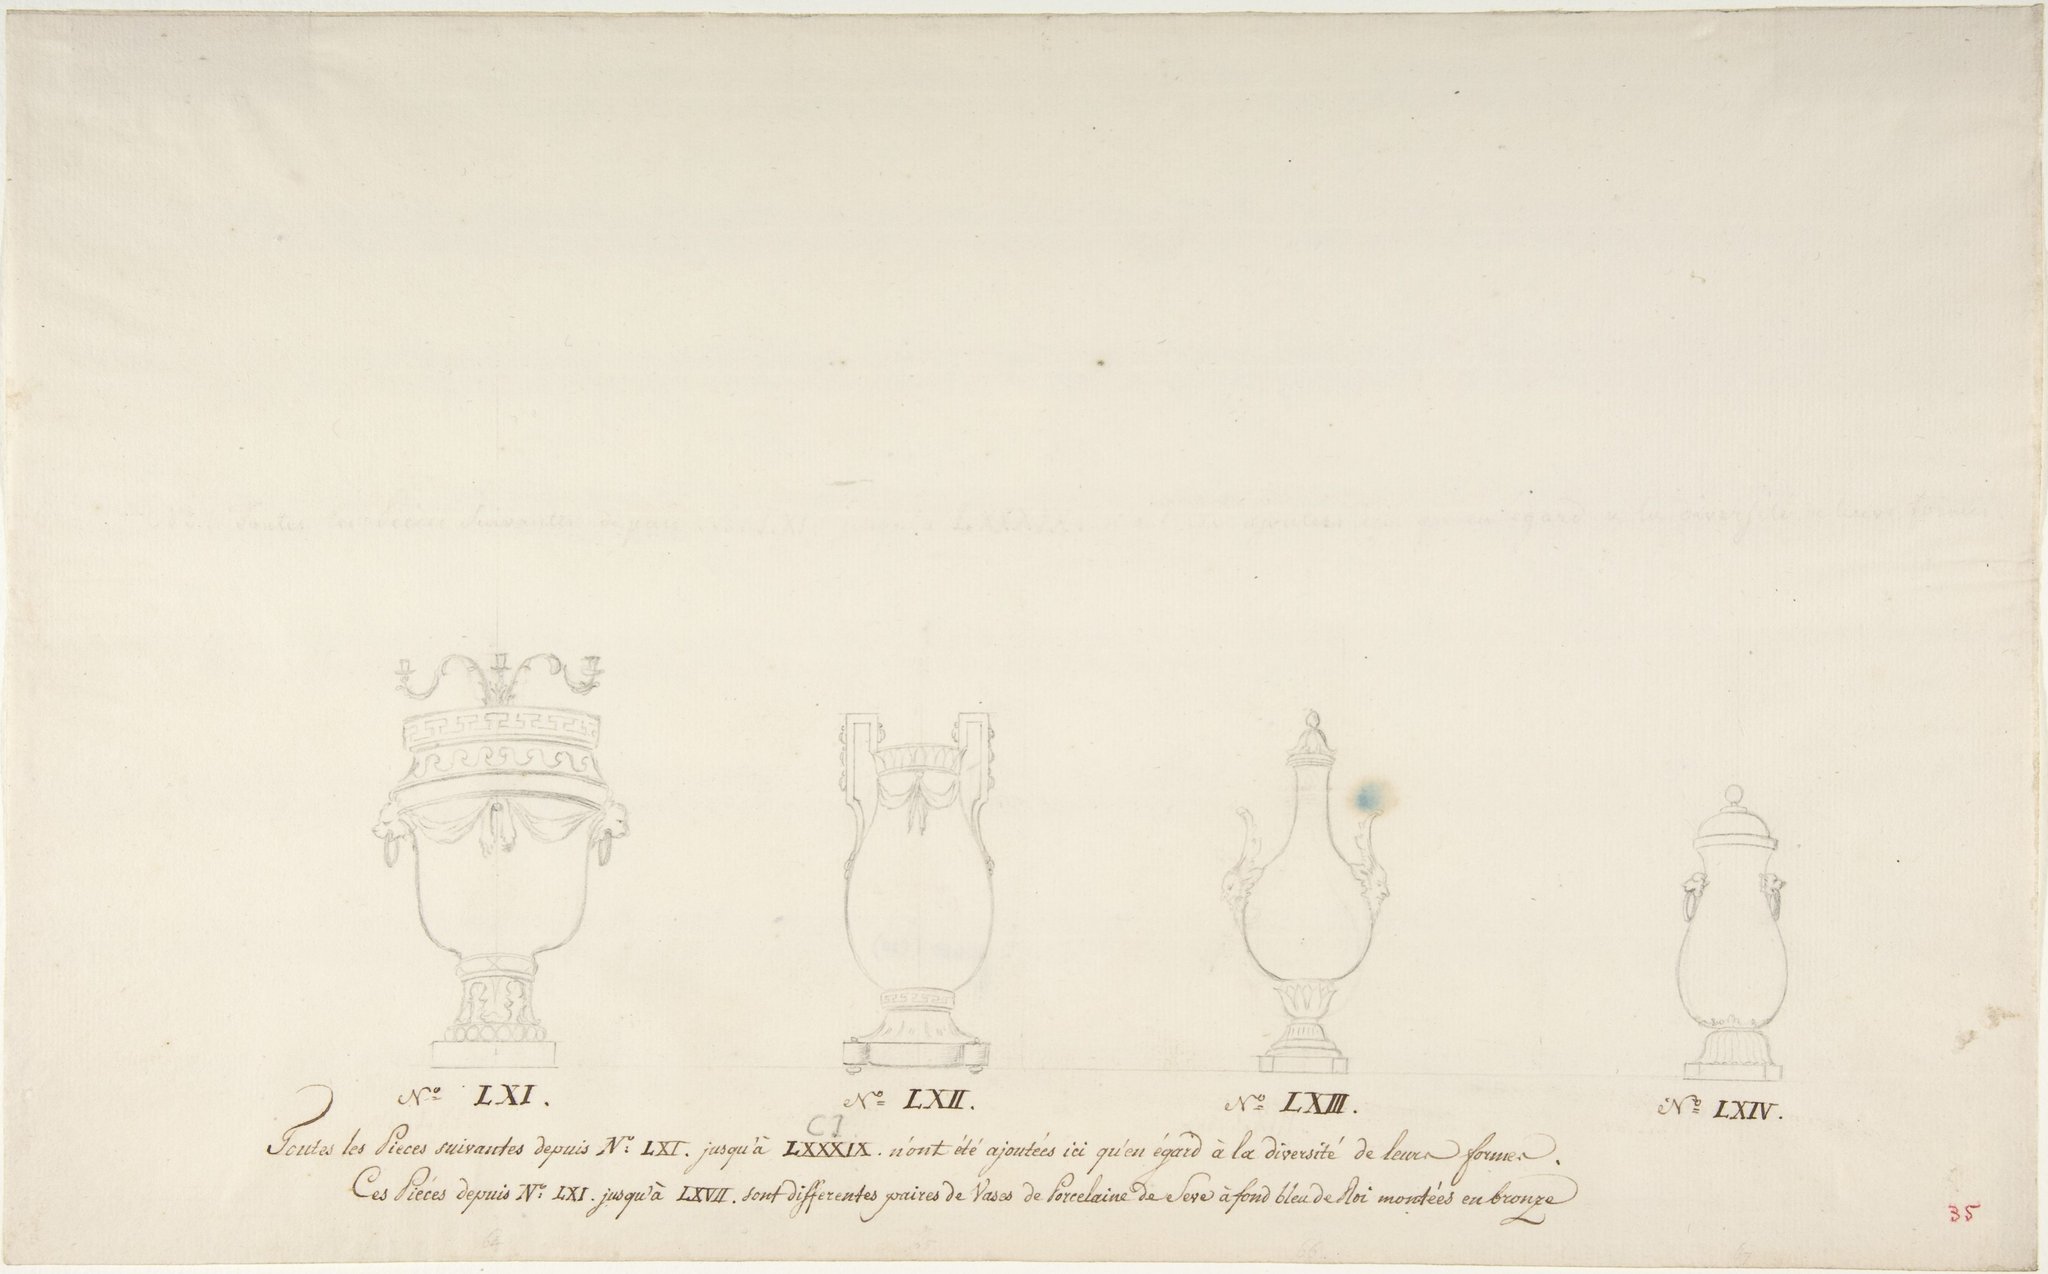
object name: drawing ornament architecture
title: Design for Four Vases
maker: anonymous, french, 18th century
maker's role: artist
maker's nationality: french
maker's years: 1700-1800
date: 1770-1785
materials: chalk, ink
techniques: pen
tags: vases